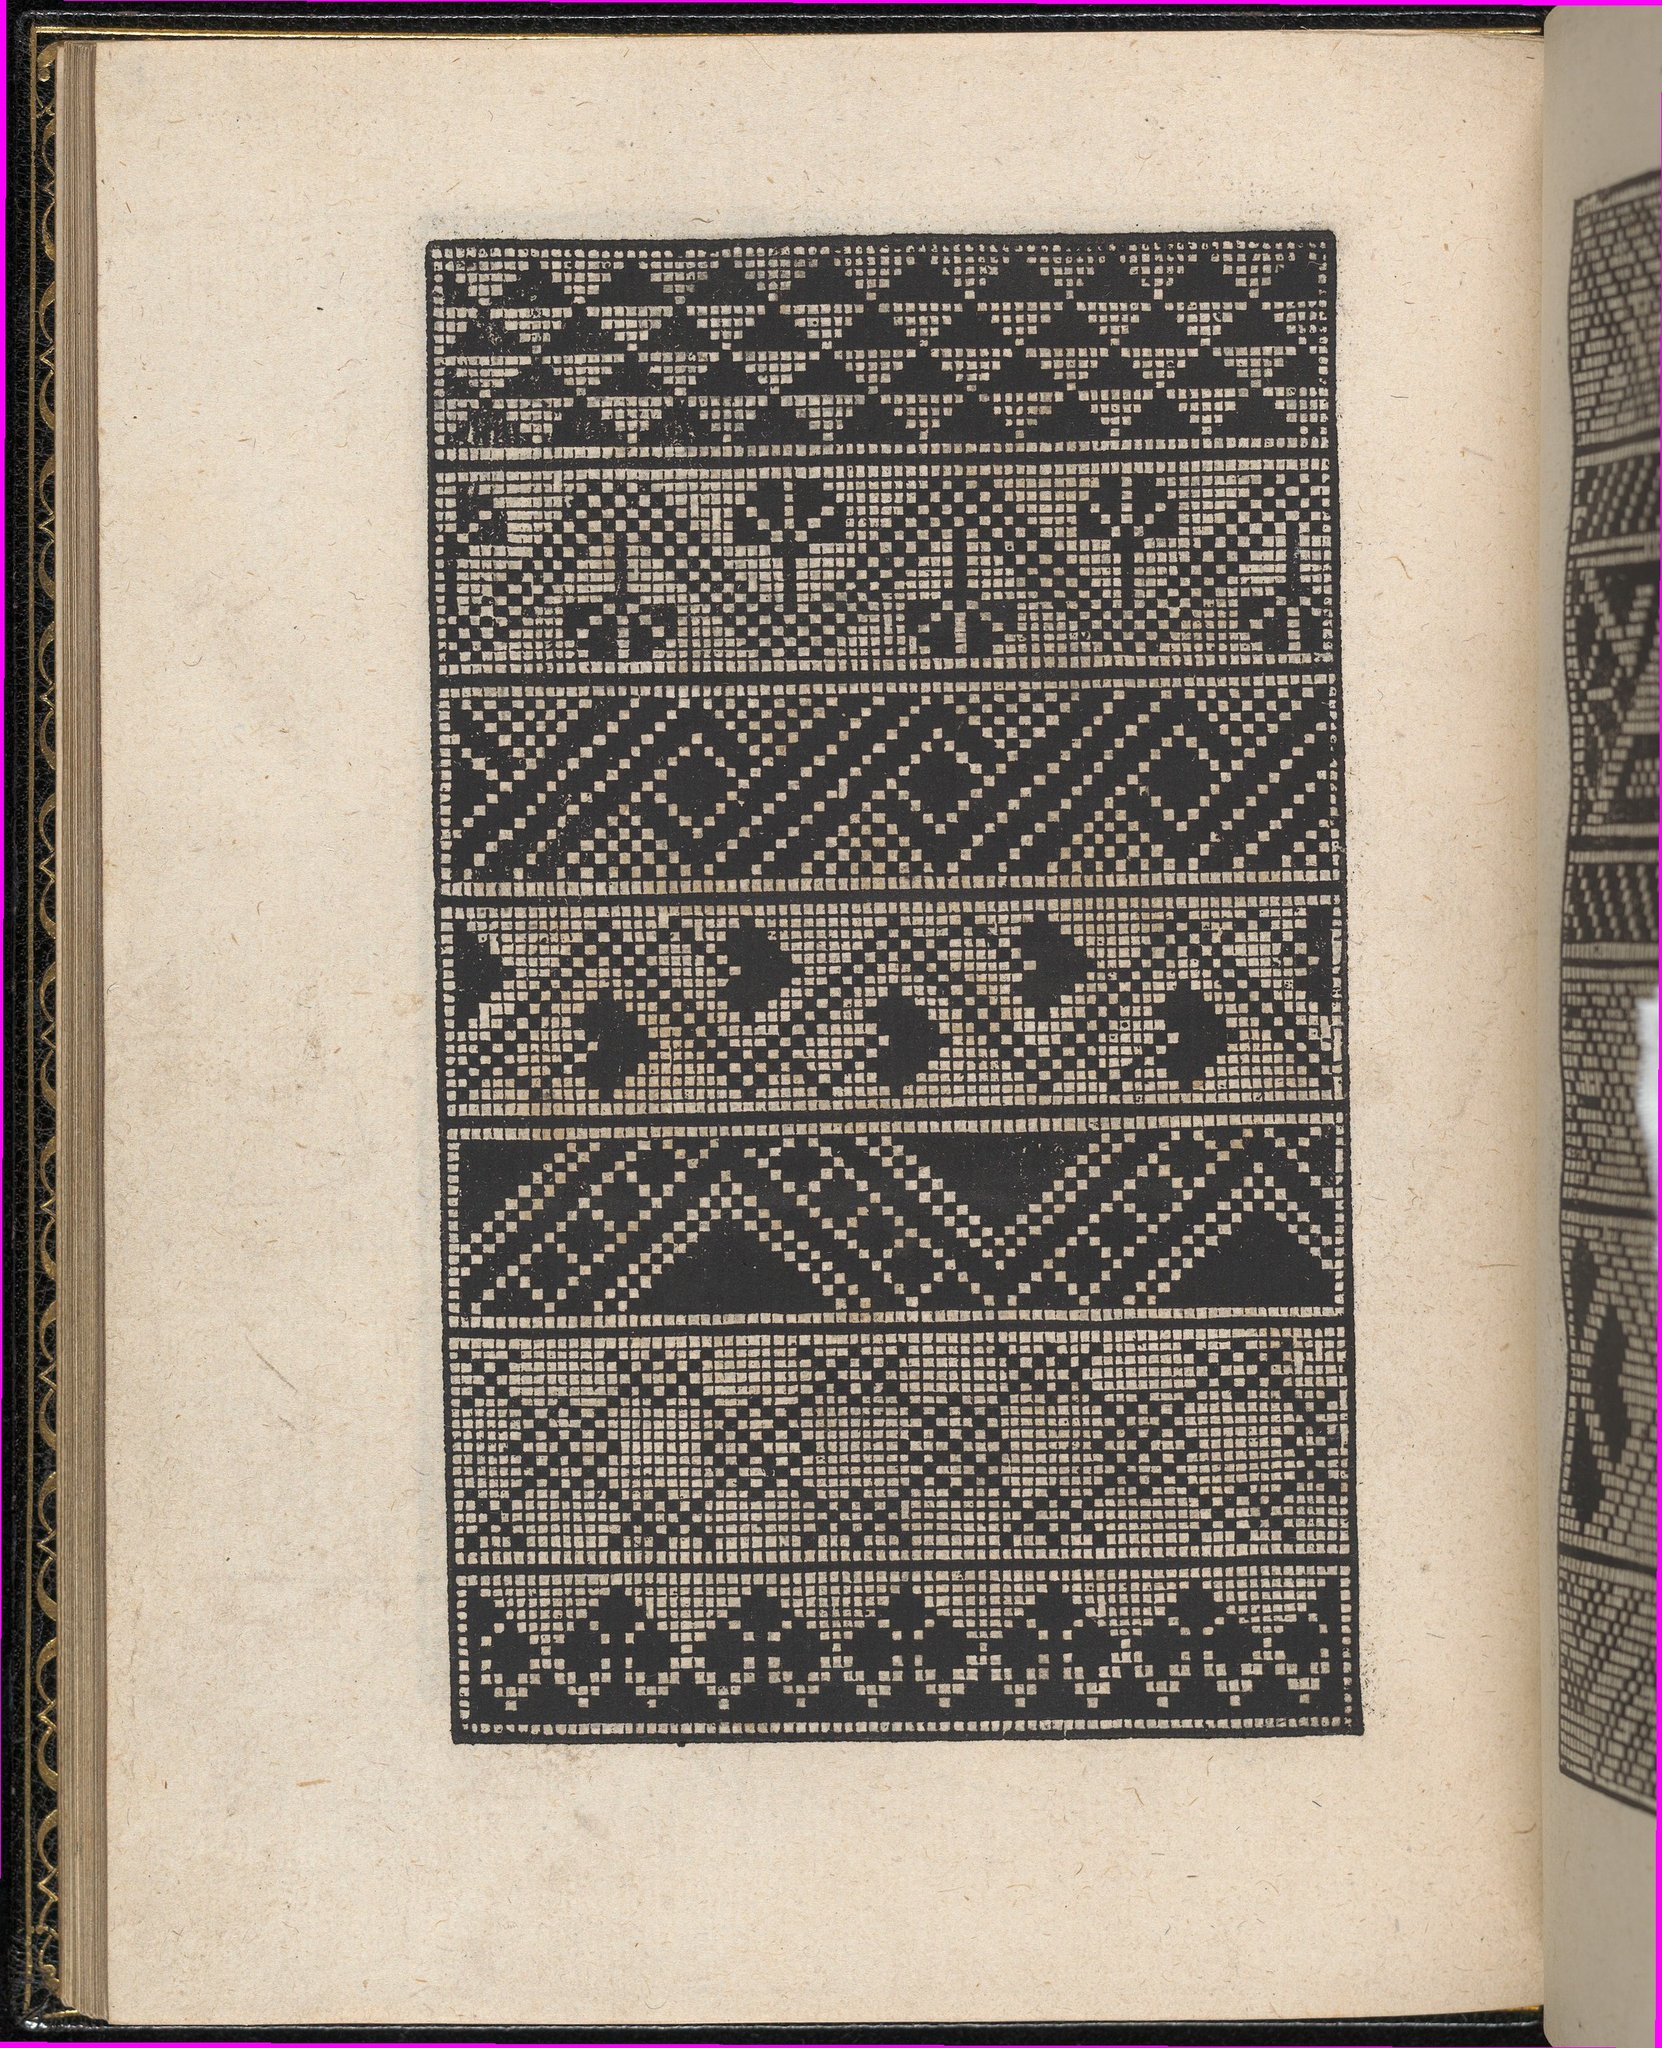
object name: book print ornament architecture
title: Page from Ein new kunstlich Modelbuch...(Page 35v)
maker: peter quentel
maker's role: publisher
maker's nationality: german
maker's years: 1500-1550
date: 1544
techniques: woodcut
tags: ornament